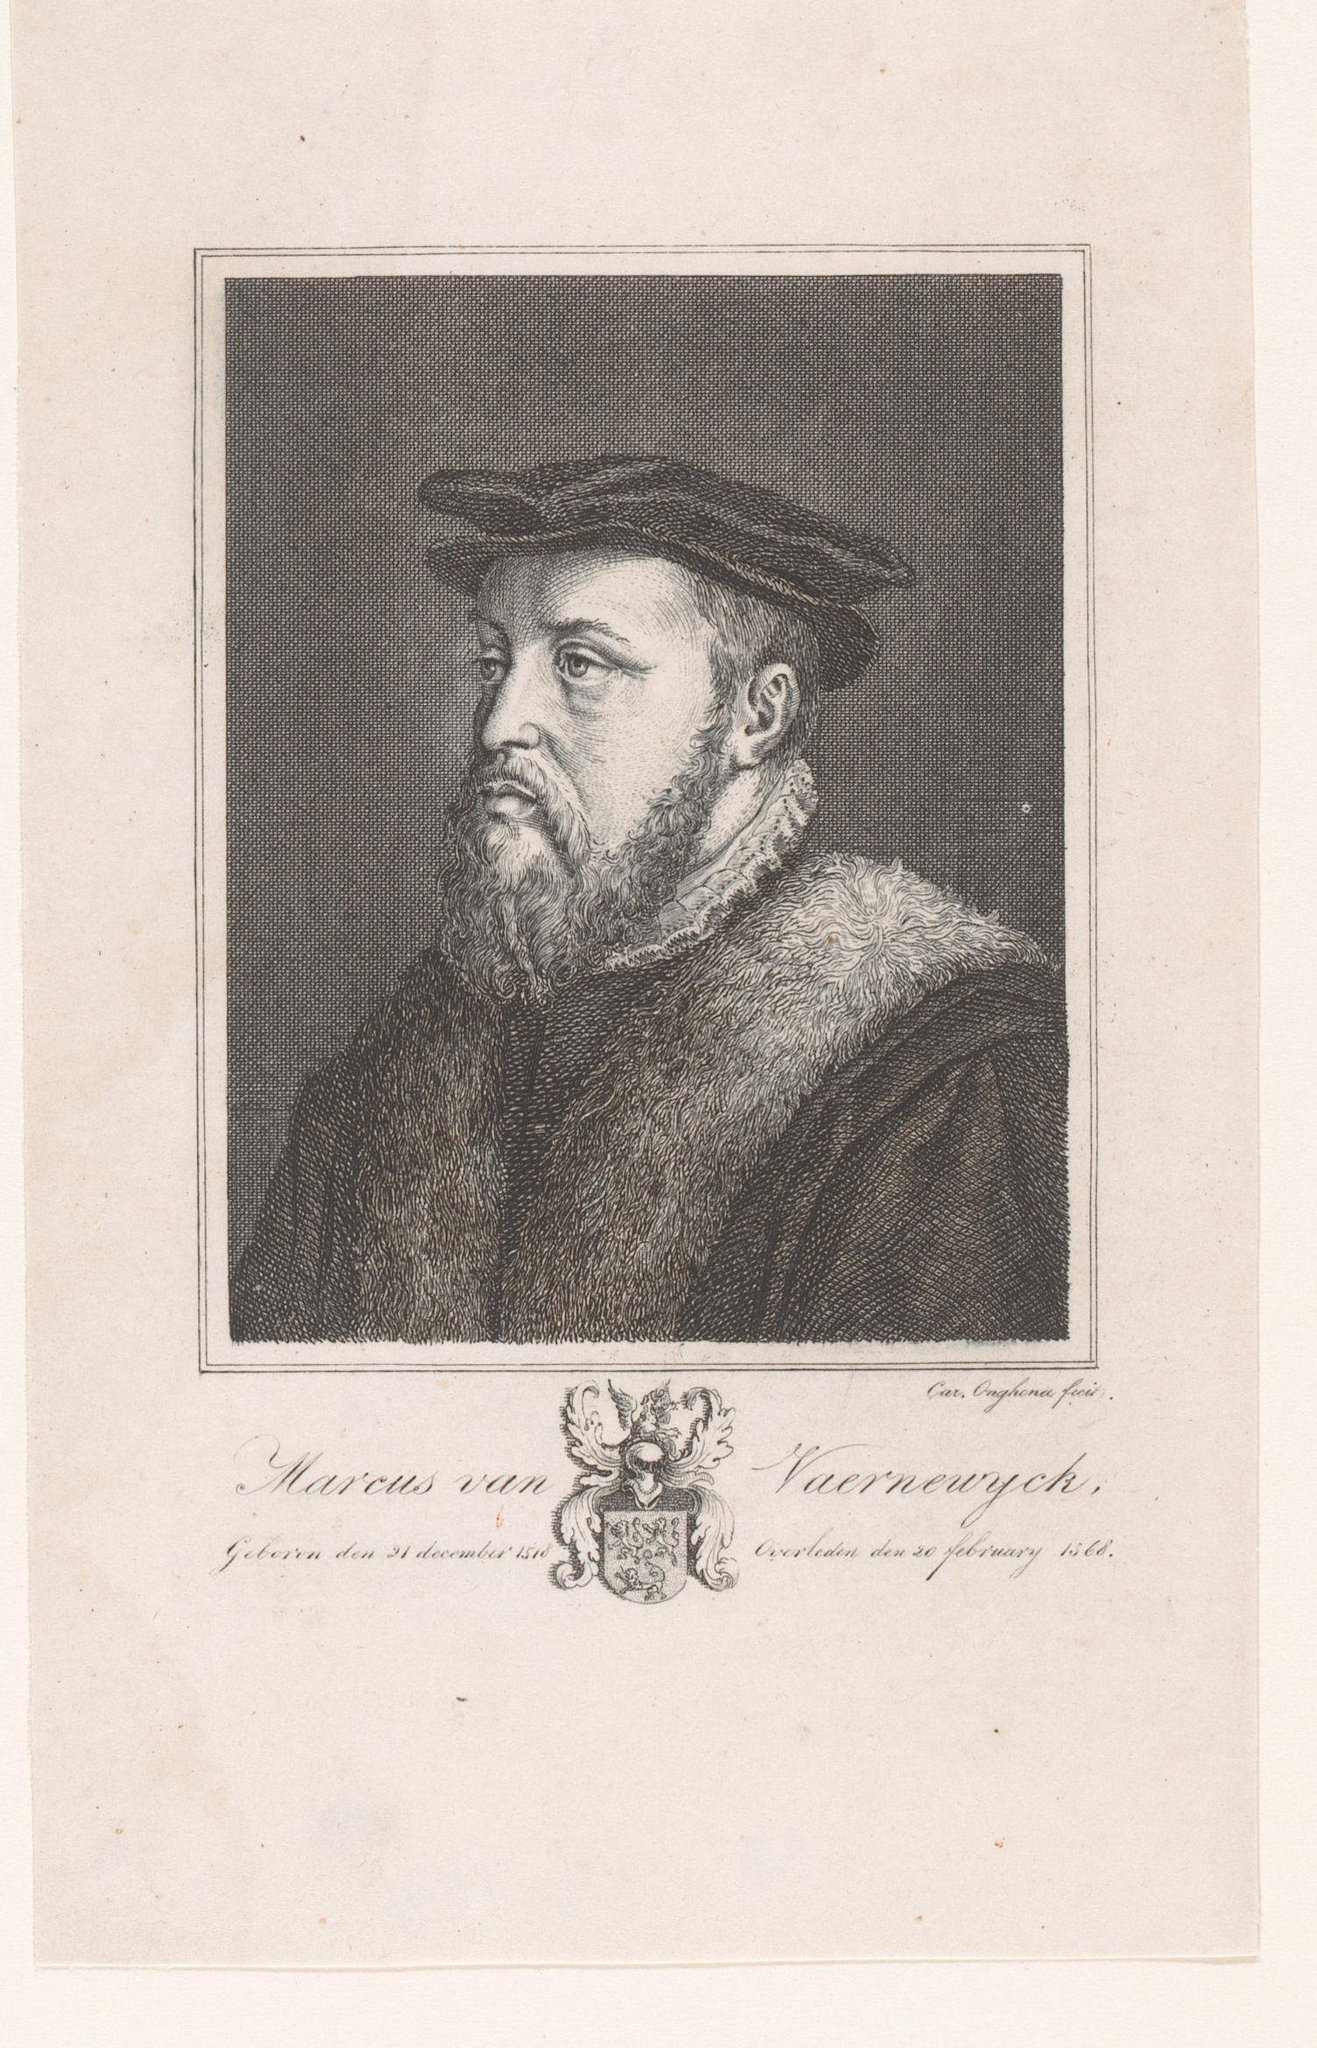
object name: print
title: Marcus van Vaernewyck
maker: charles onghena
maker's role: print maker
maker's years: 1806-1886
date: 1816-1886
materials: paper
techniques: etching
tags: ghent, historical persons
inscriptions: collector's mark: Lugt 2228